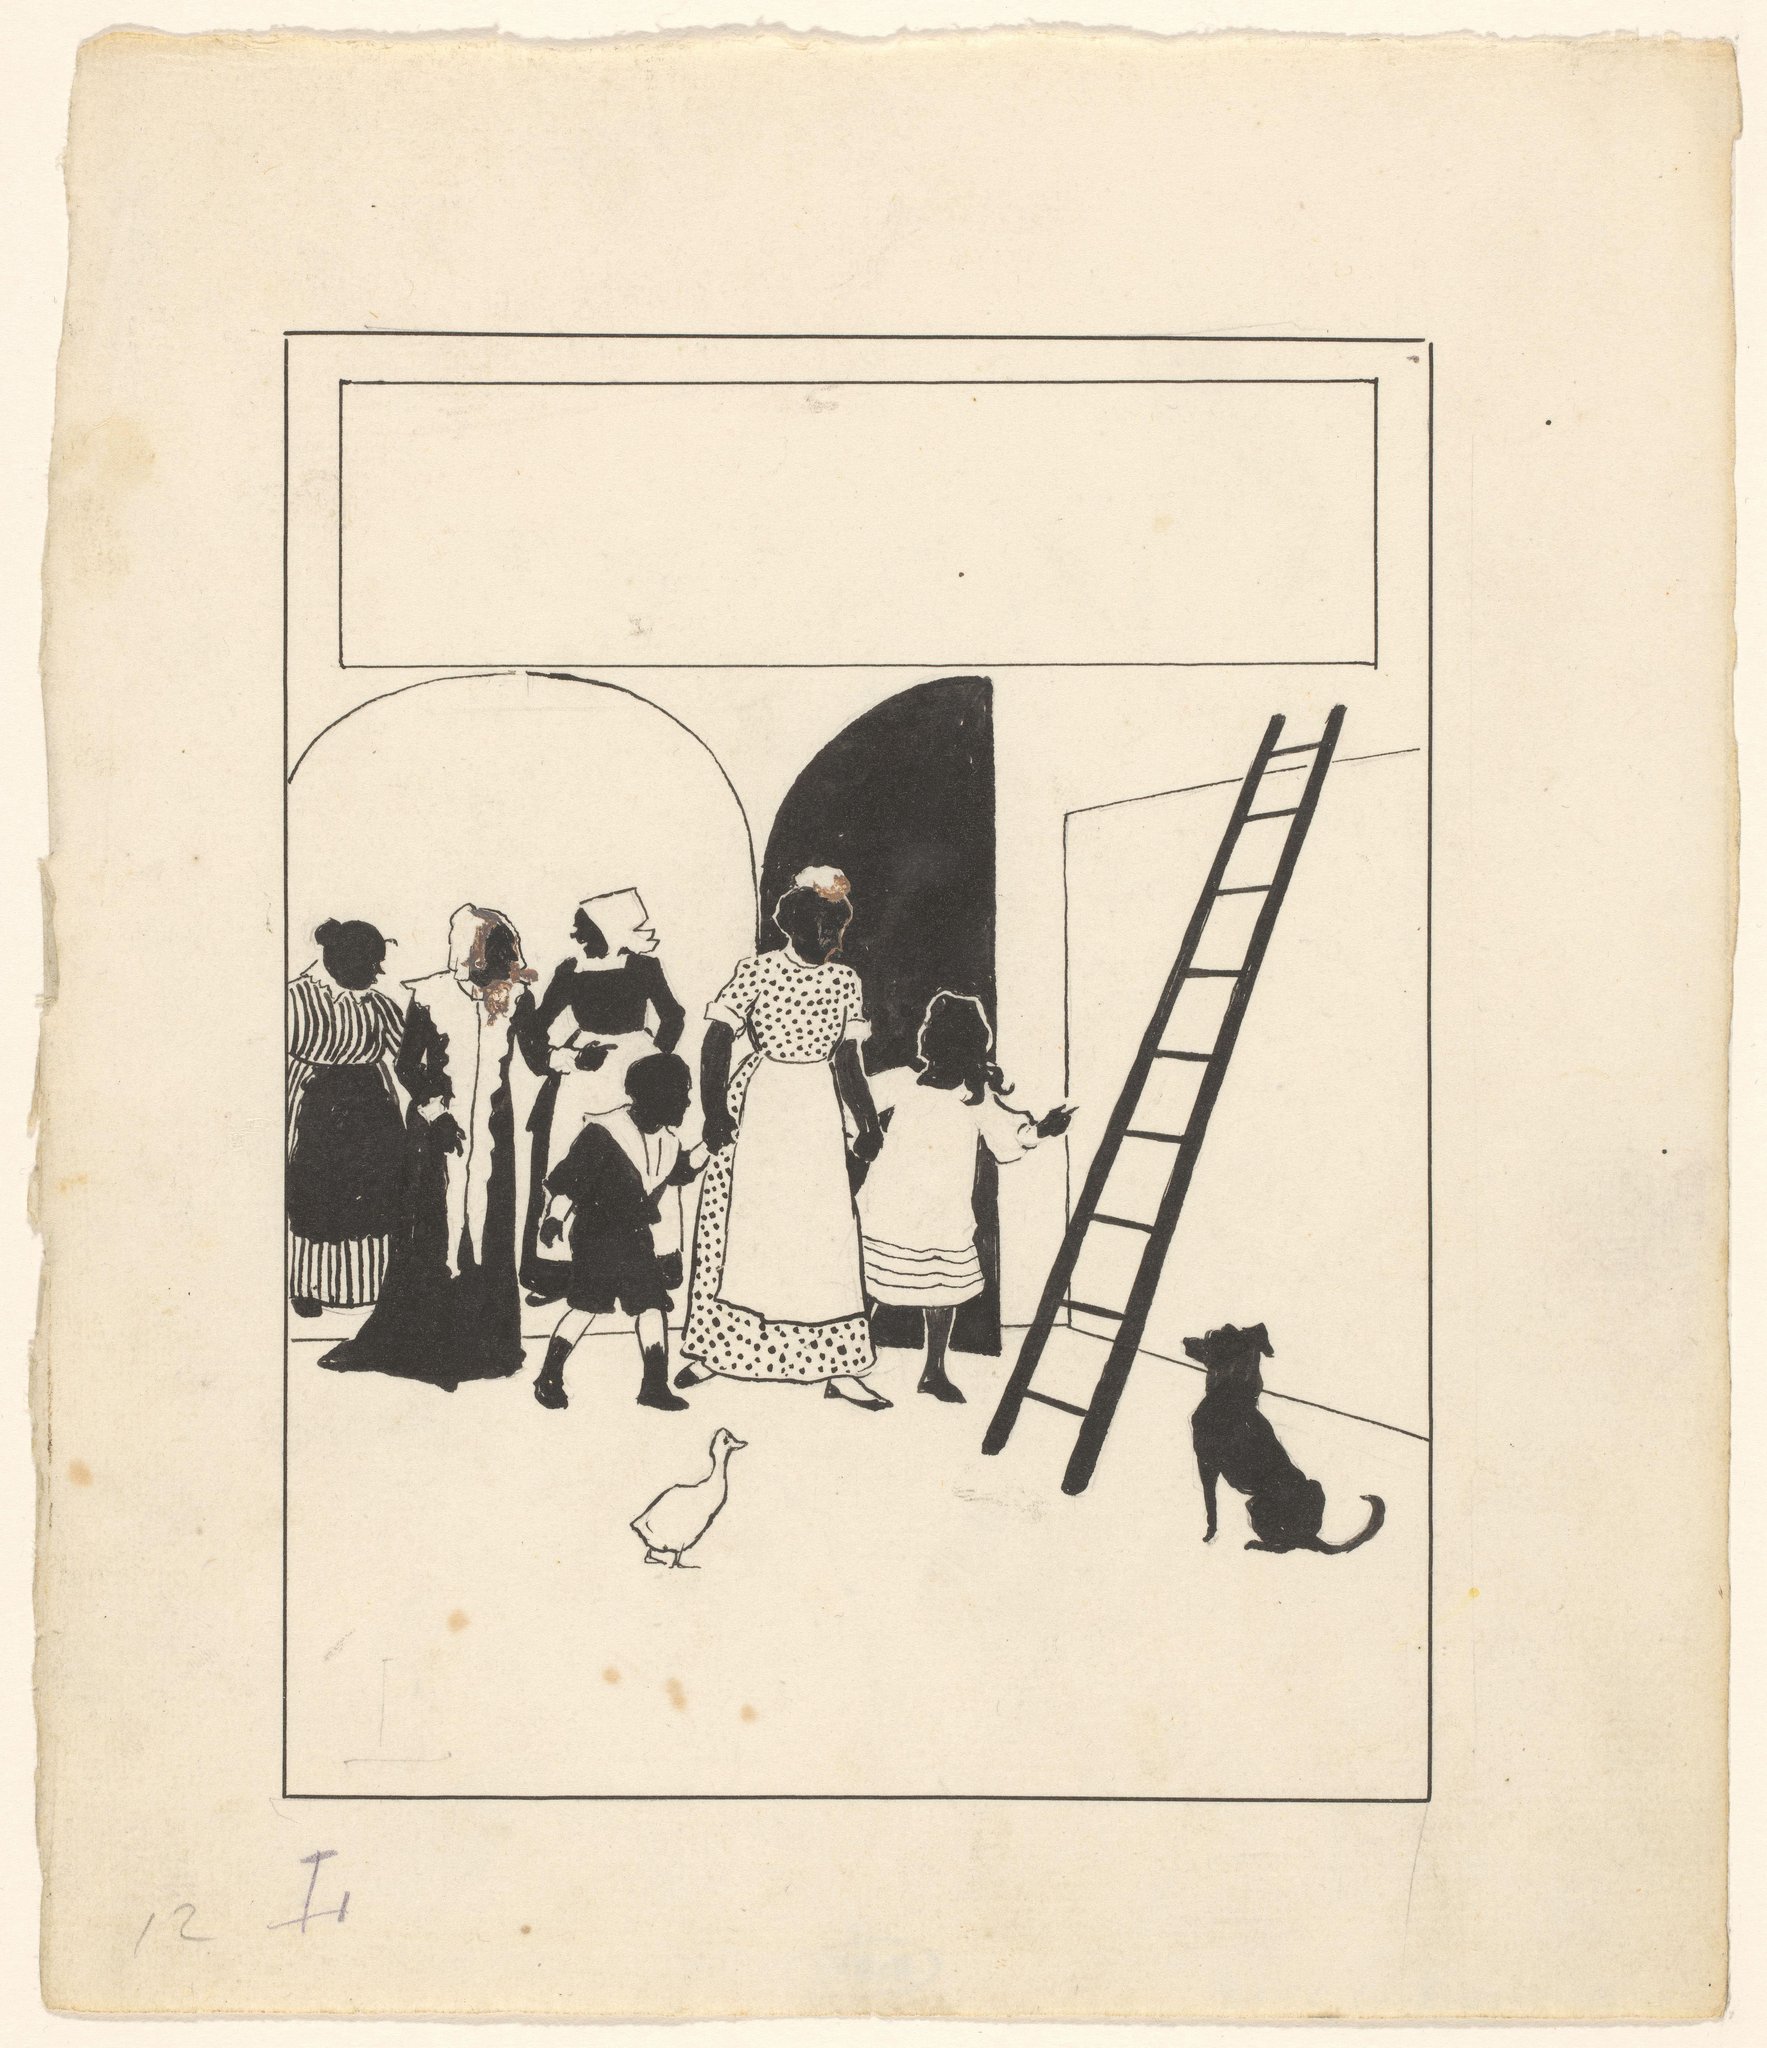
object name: boekillustratie ontwerp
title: Vrouwen en kinderen bij een ladder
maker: Anonymous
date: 1880-1910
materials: paint, ink, paper, pencil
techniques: brush, pen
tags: animals, ladder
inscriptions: collector's mark: Lugt 2228a, number: ‘12 I’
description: Een groep van vier vrouwen, een jongen en meisje staan bij een ladder die tegen een muur leunt. Een hond en gans kijken toe.